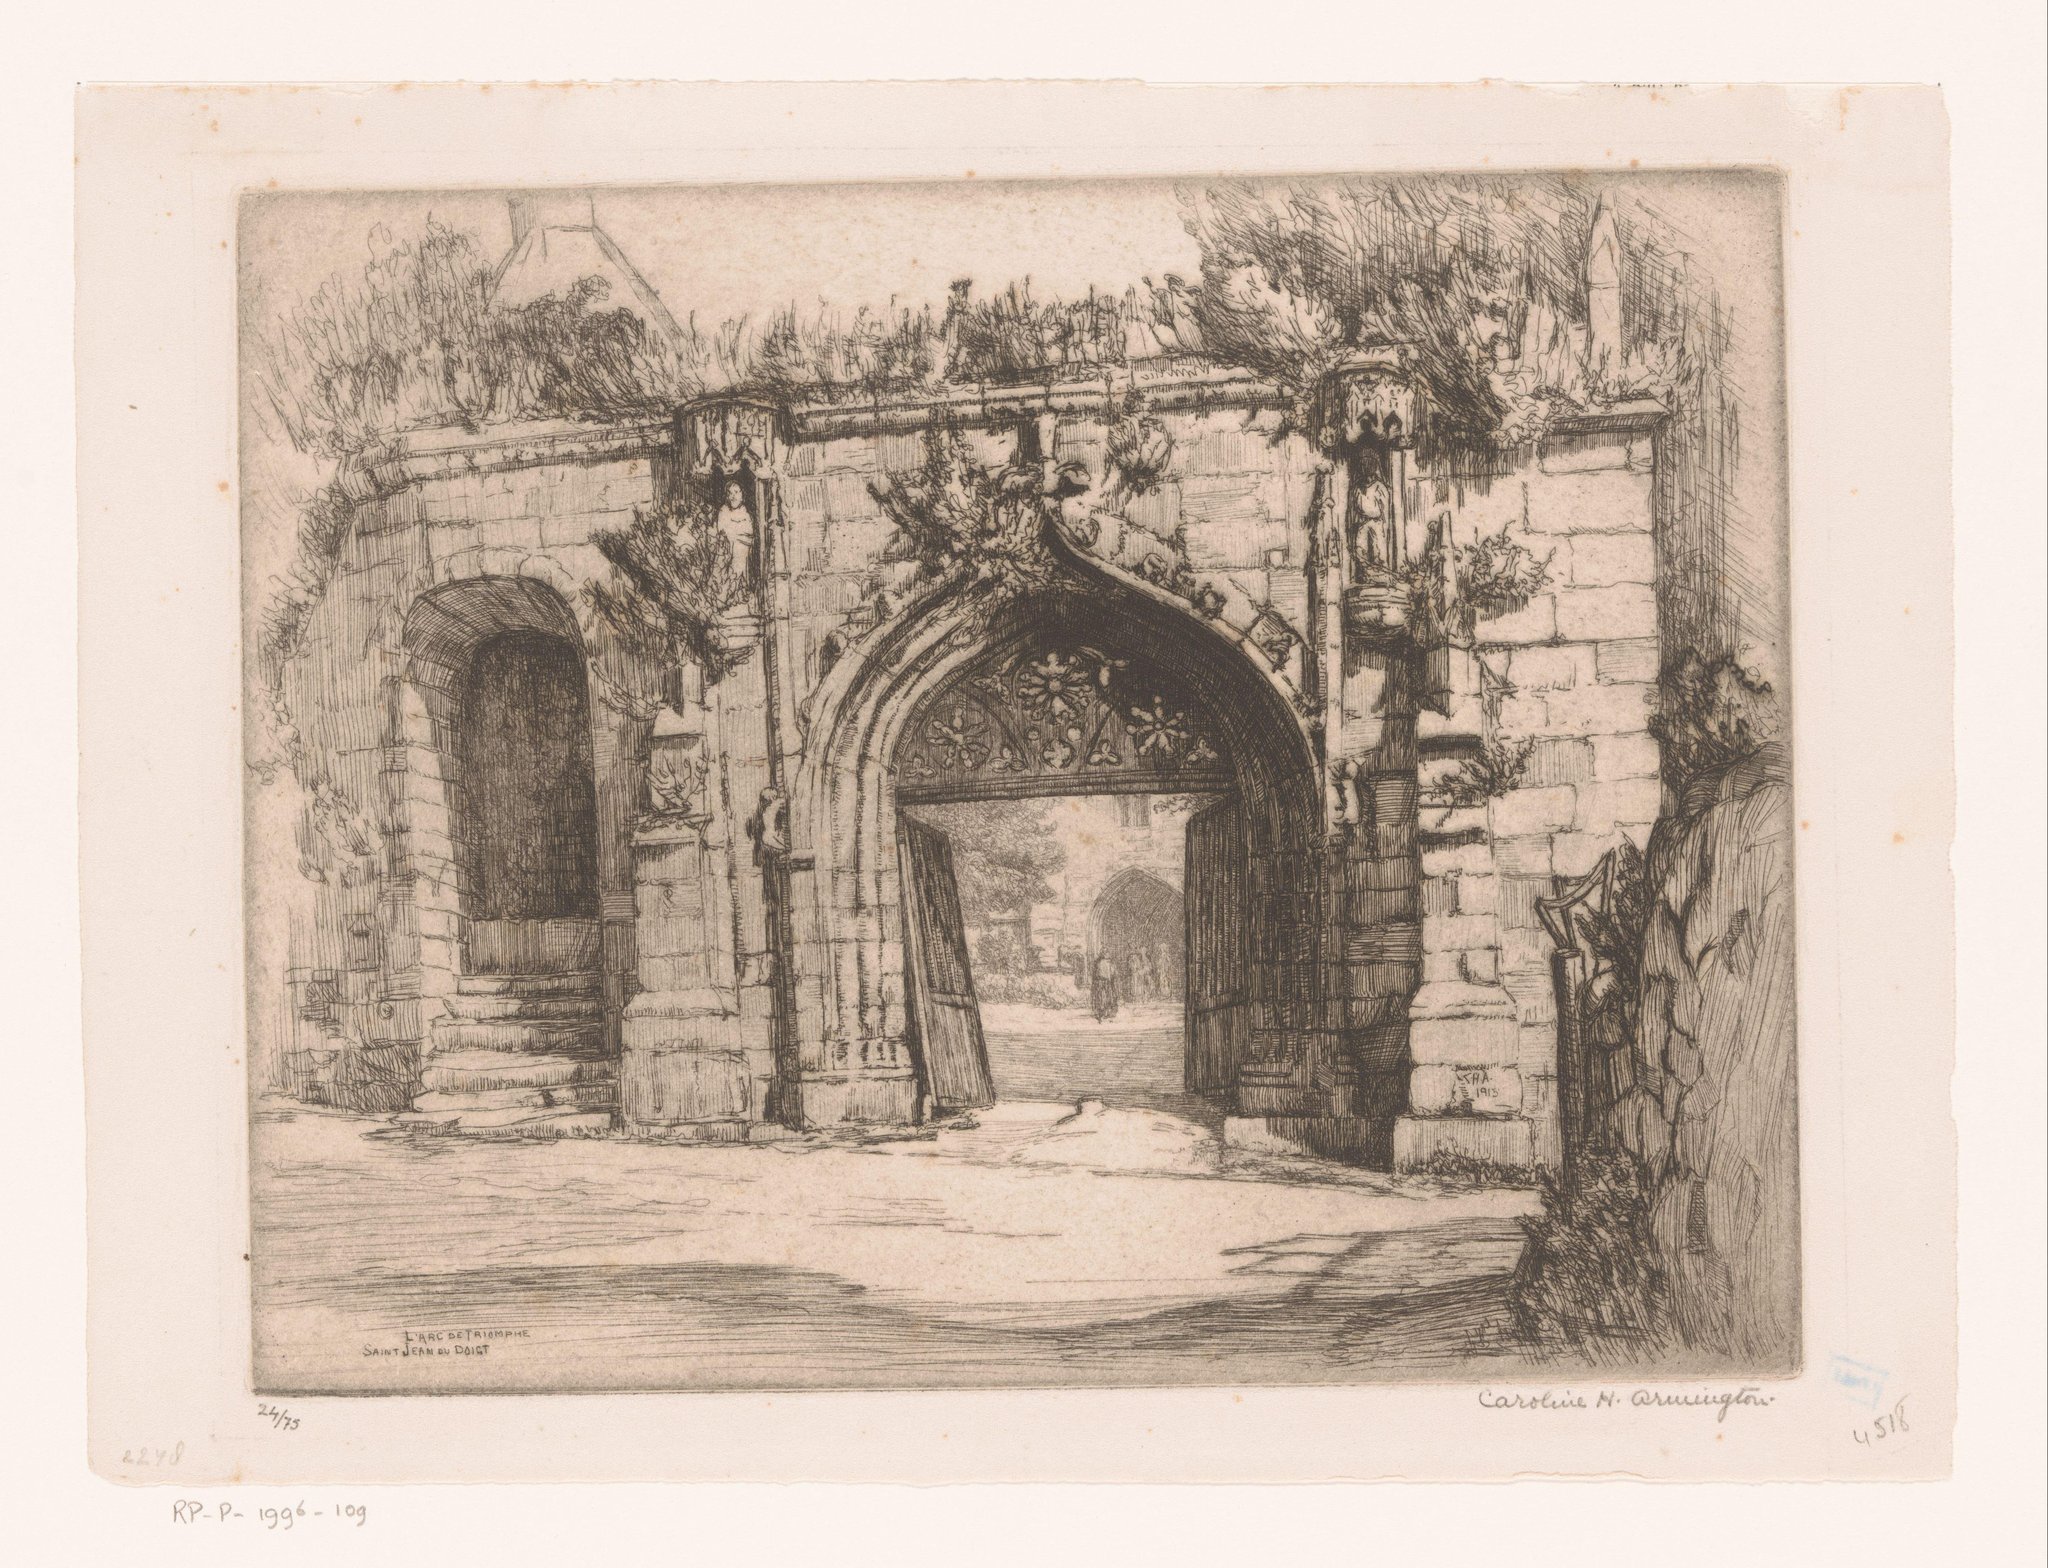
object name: print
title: Saint-Jean-du-Doigt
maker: caroline helena armington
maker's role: painter, print maker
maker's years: 1875-1939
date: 1915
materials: paper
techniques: drypoint, etching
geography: canada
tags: gate, entrance, churchyard, cemetery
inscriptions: inscription: ‘L'Arc de triomphe / Saint Jean du Doigt’, collector's mark: Lugt 2760, collector's mark: ‘vD’, collector's mark: Lugt 2228, collector's mark: Lugt 5101, collector's mark: Lugt 3761, signature: ‘in de marge met potlood: Caroline H. Armington’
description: Gezicht op de poort 'Arc de Triomphe' in de muur van het kerkhof bij de Saint Jean du Doigt, 1915, met vervallen openstaande houten deuren. Doorkijkje naar kerk.